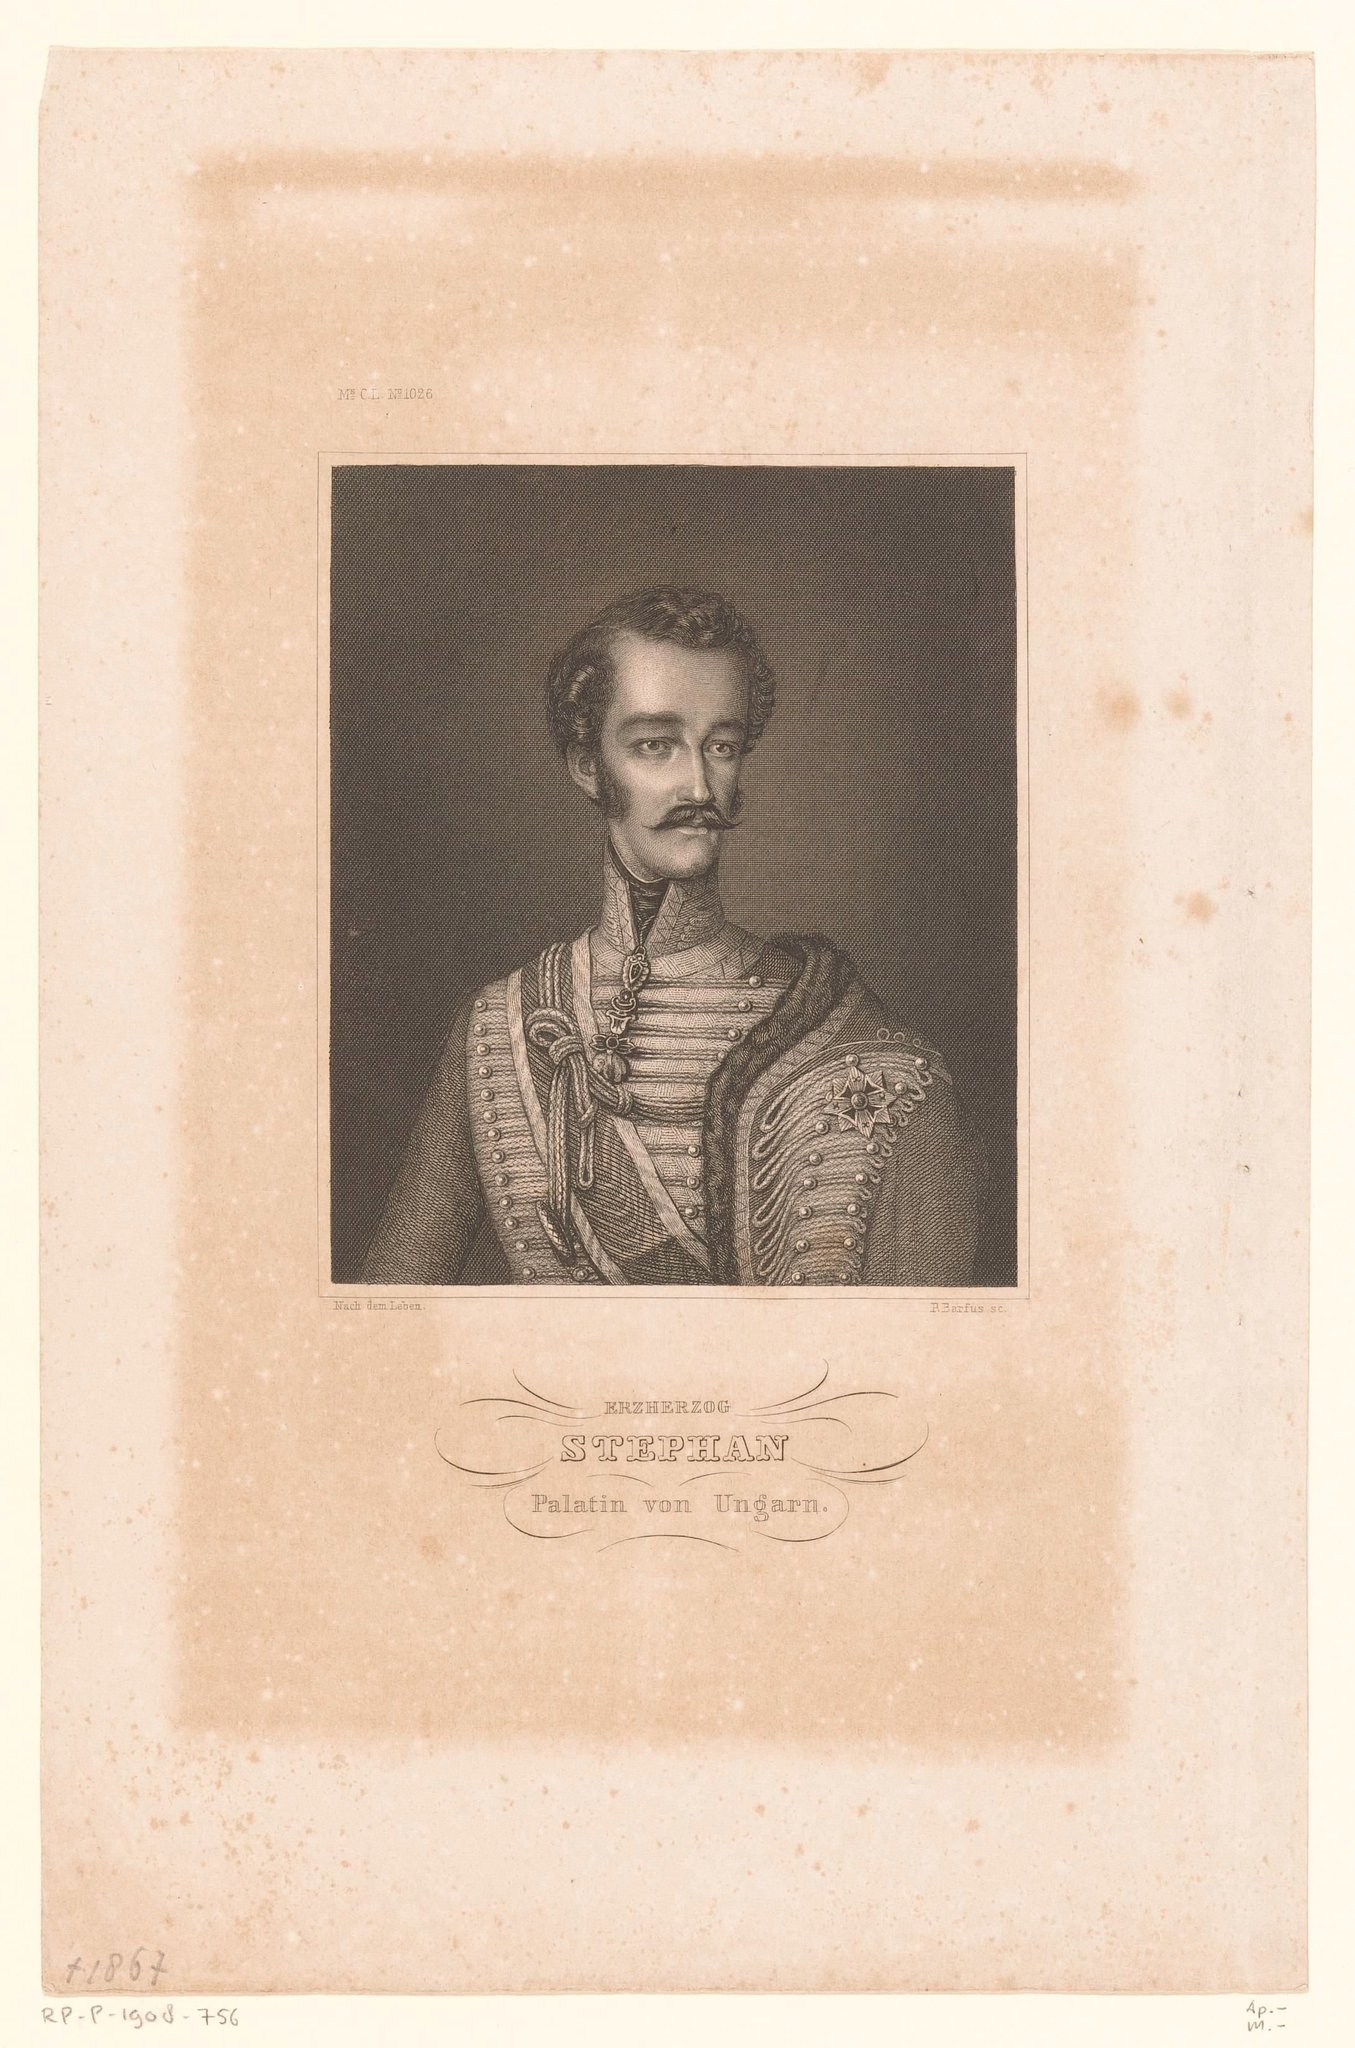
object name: print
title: Portret van Stephan, aartshertog van Oostenrijk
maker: paul barfus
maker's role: print maker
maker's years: 1823-1895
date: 1847-1895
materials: paper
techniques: engraving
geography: germany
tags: historical persons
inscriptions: collector's mark: Lugt 2228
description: Prent mogelijk afkomstig uit: Meyer, Joseph. Das große Conversations-Lexikon für die gebildeten Stände.